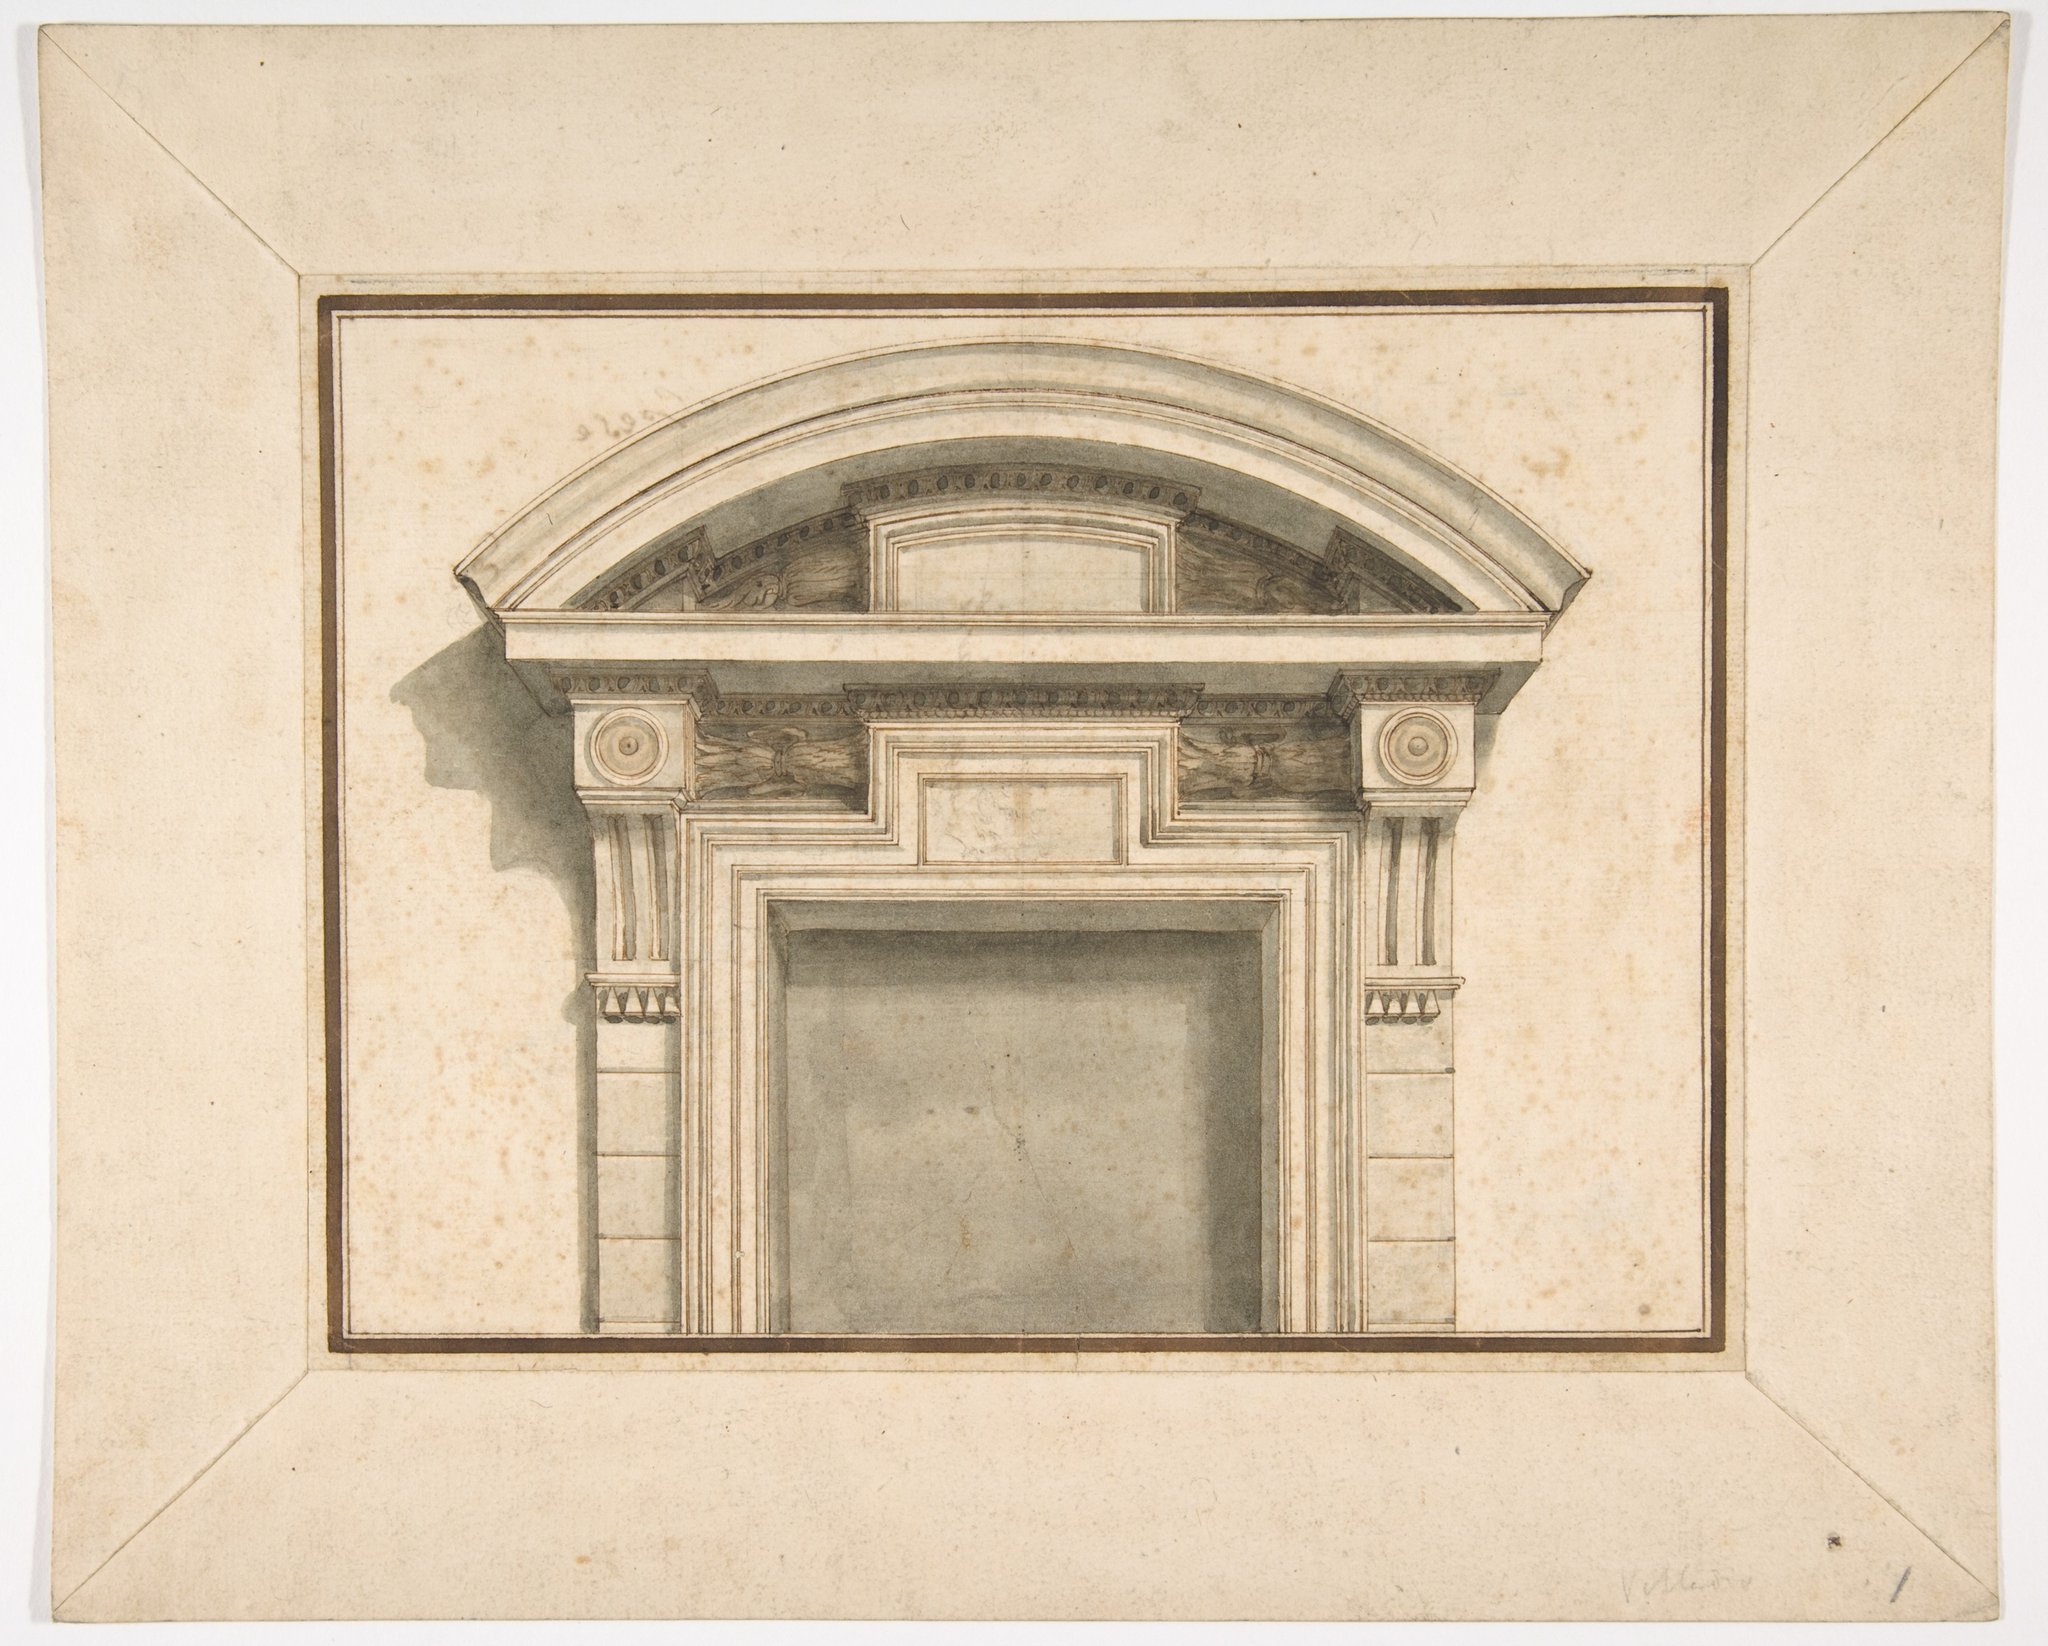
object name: drawing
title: Drawing for a Door Frame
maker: lorenzo sarti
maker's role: artist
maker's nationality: italian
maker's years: 18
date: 1701-1800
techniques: pen, wash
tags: architecture